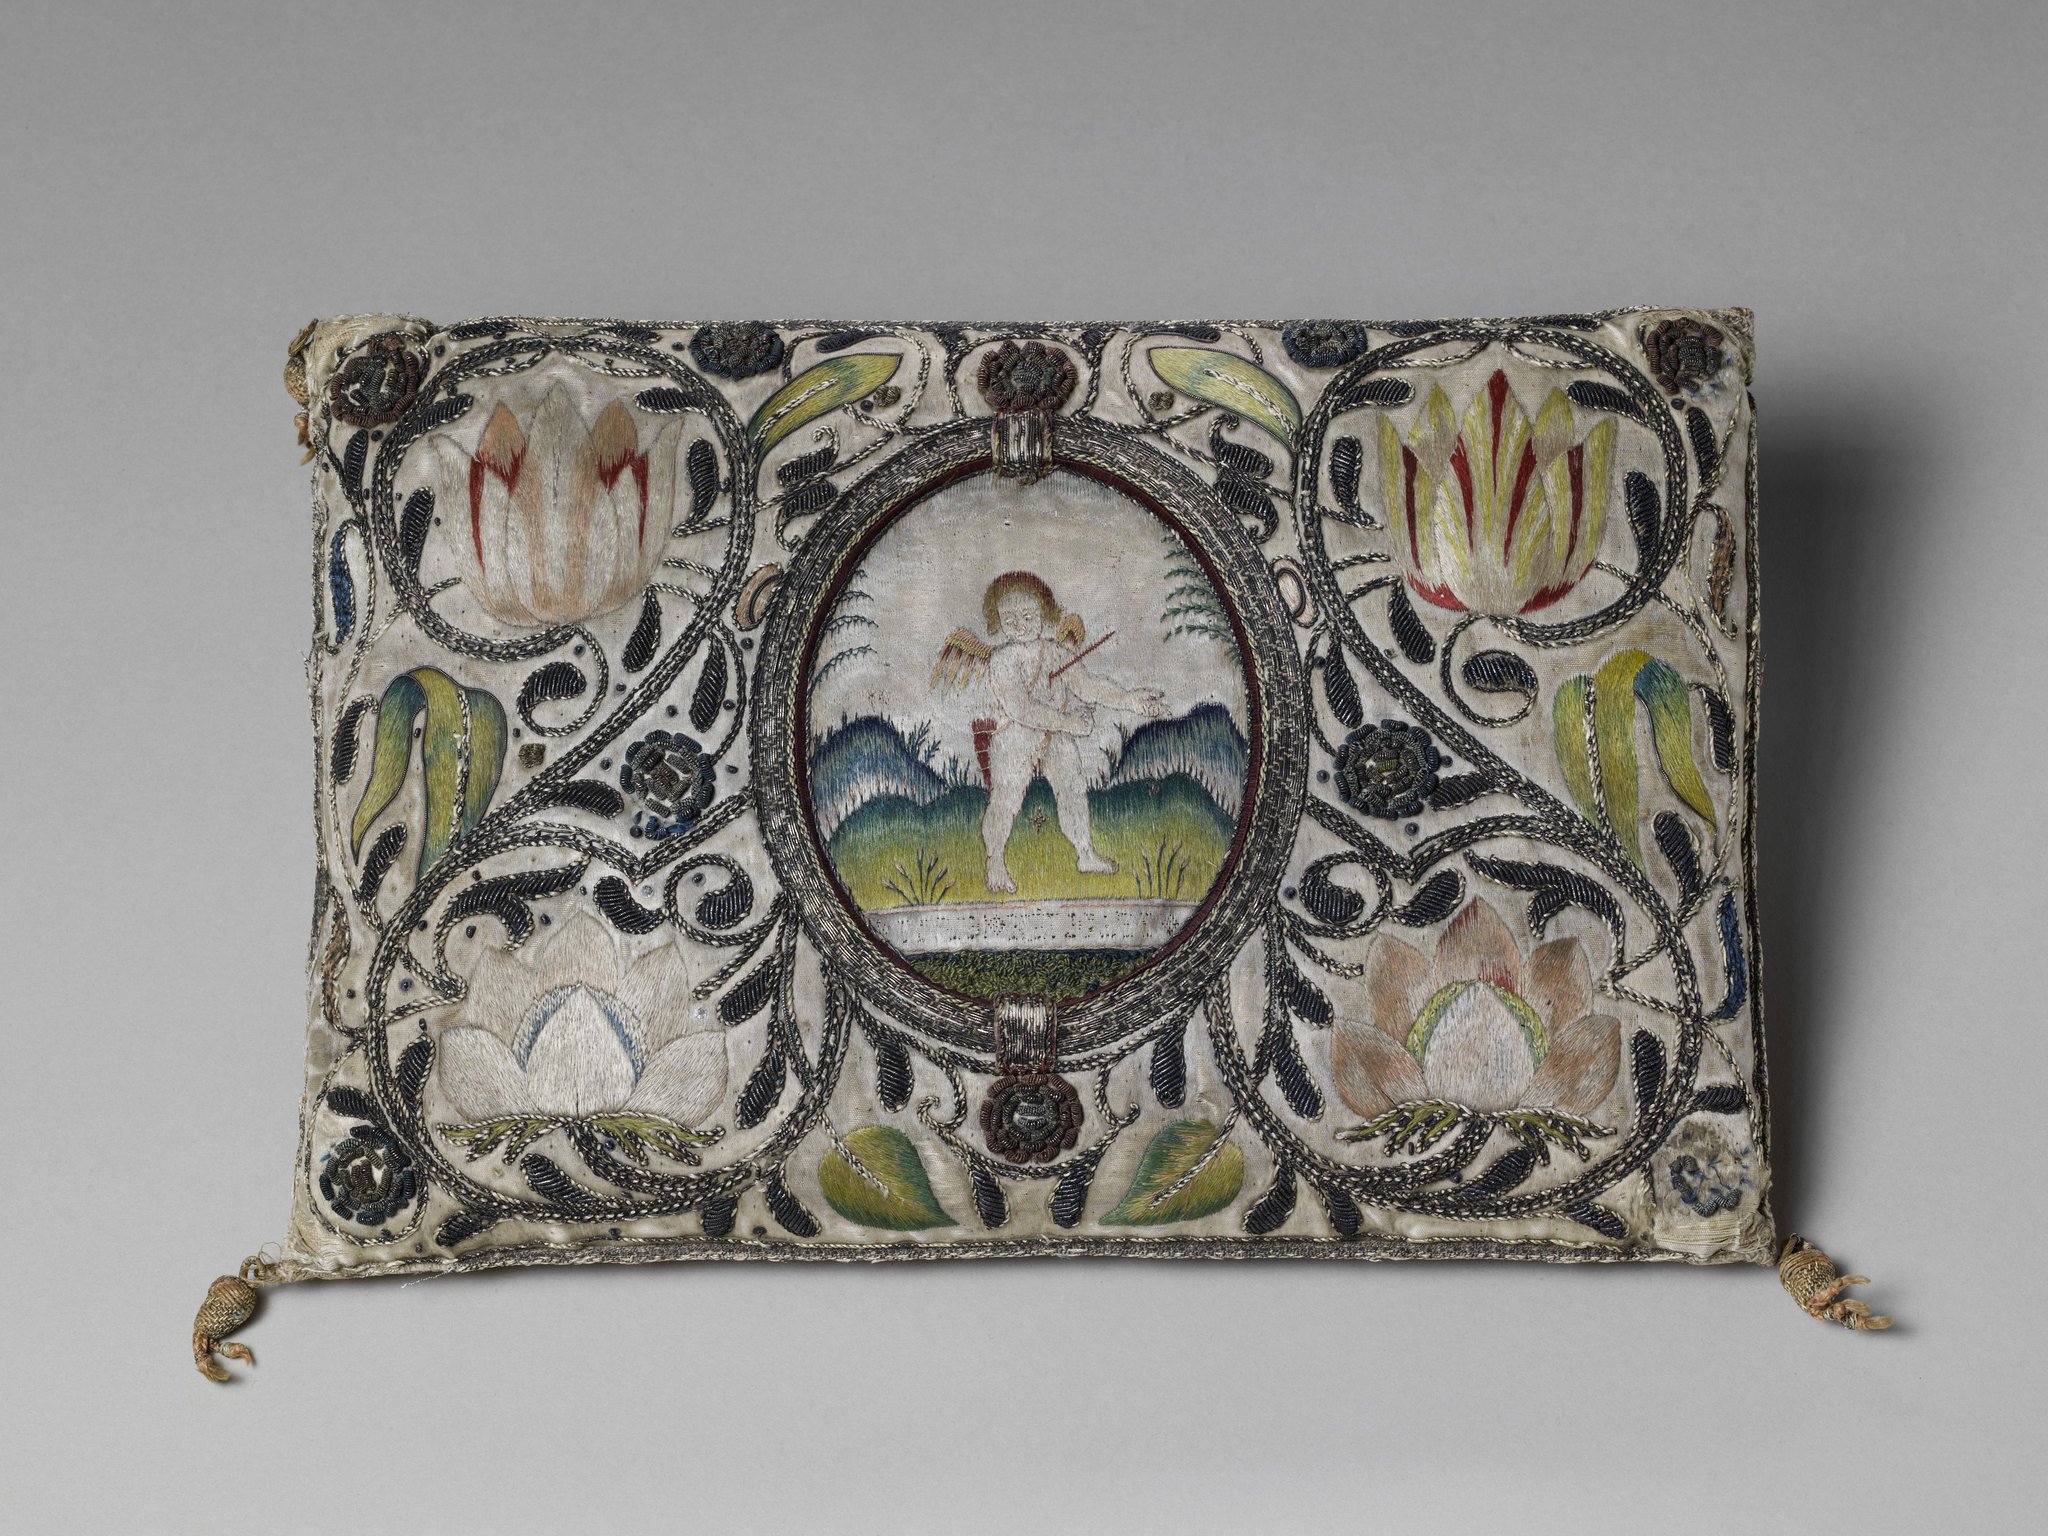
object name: cushion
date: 1620-1640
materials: metal thread, textile, silk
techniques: embroidery, stitching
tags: cupid,flowers